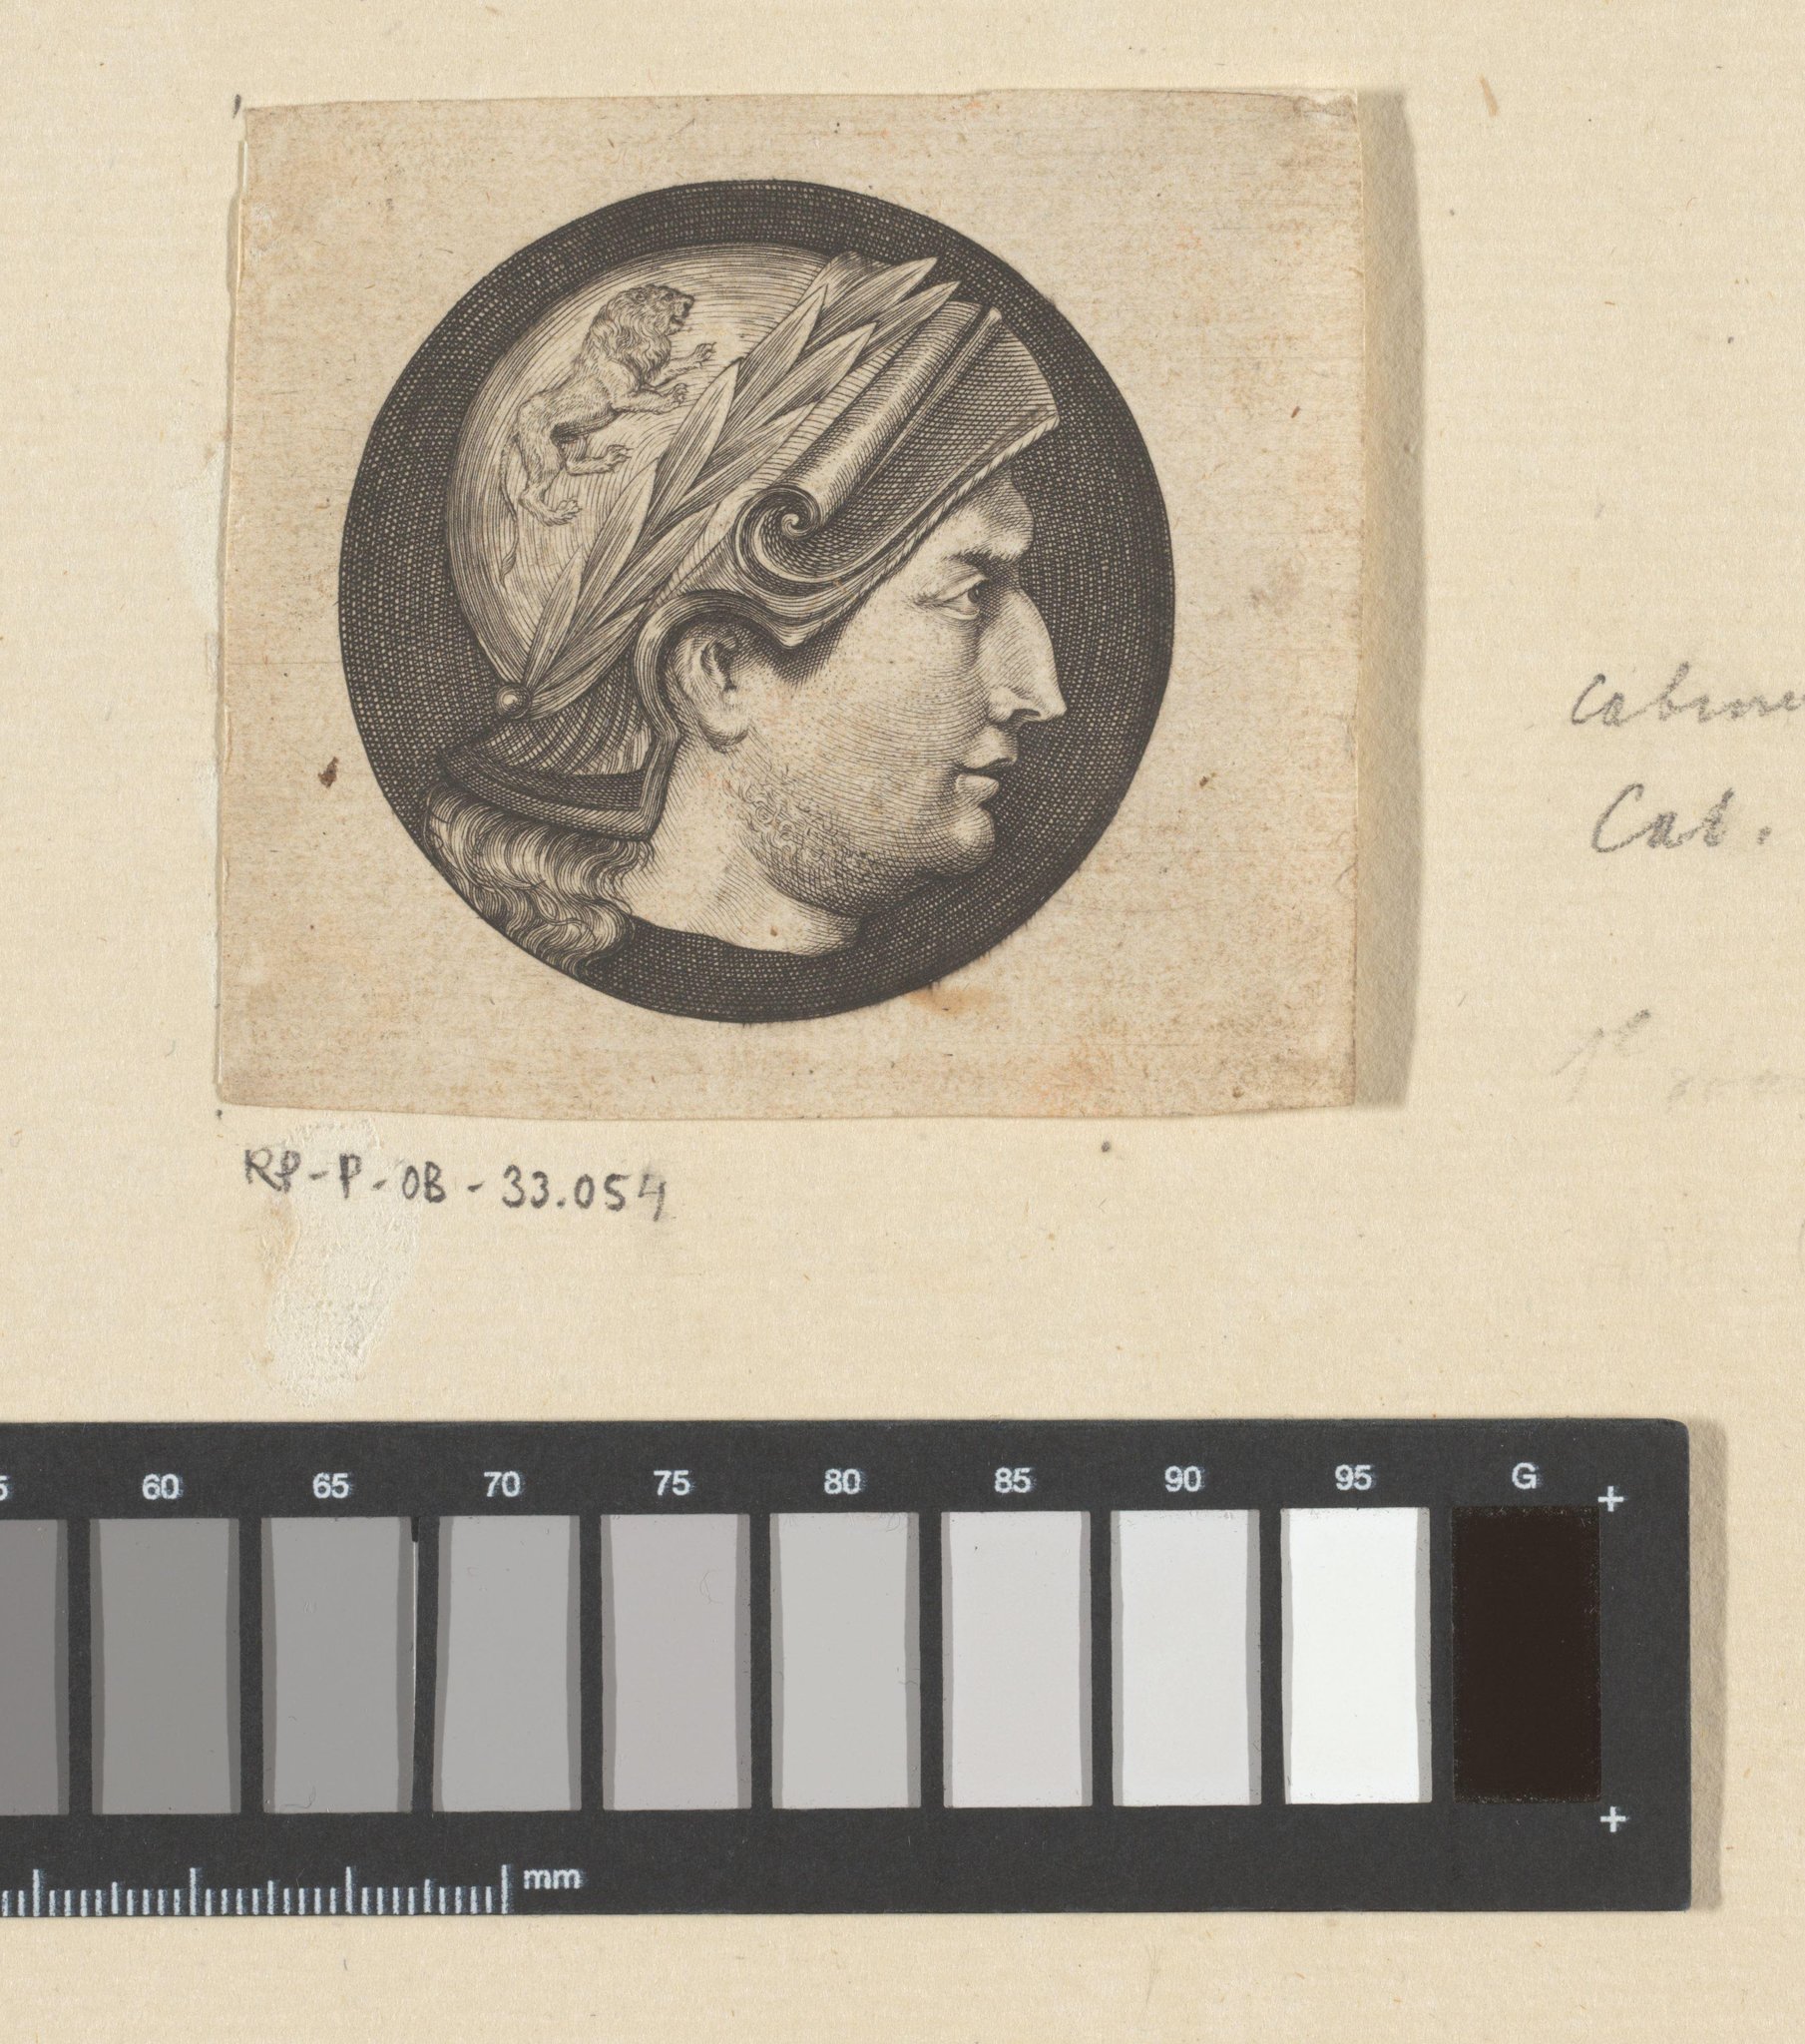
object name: print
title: Buste van Alexander de Grote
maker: lucas vorsterman (i)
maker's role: print maker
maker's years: 1595-1675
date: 1620-1622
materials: paper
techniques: engraving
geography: antwerp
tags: portrait of alexander the great (+ belonging to greek history)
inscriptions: collector's mark: Lugt 240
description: Alexander de Grote als Hercules. Deel van een prent uit de serie 'Varie Figueri de Agati Antique' naar Peter Paul Rubens, van in totaal negen prenten waarvan vermoedelijk vijf door Lucas Vorsterman I en vier door Paulus Pontius.